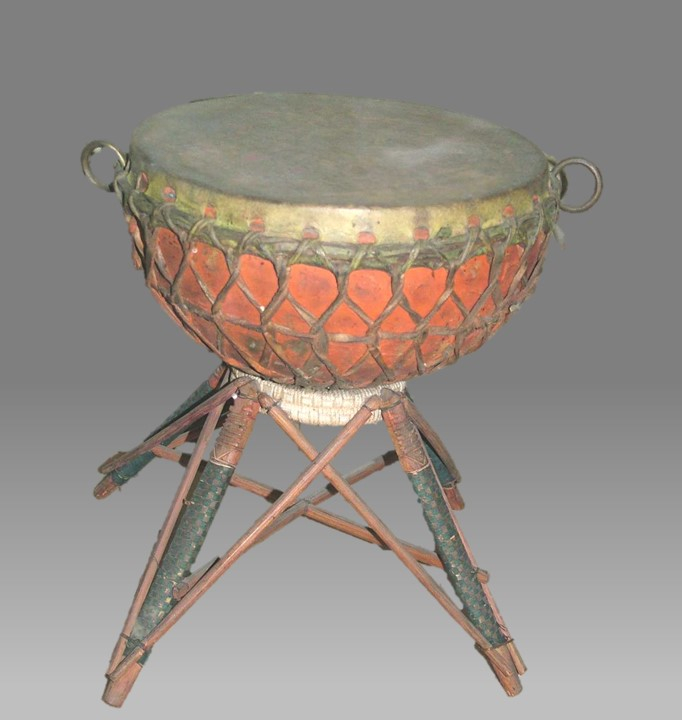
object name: tabl sami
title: Tabl Šamī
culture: moroccan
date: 1867-1900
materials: pottery, skin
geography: morocco